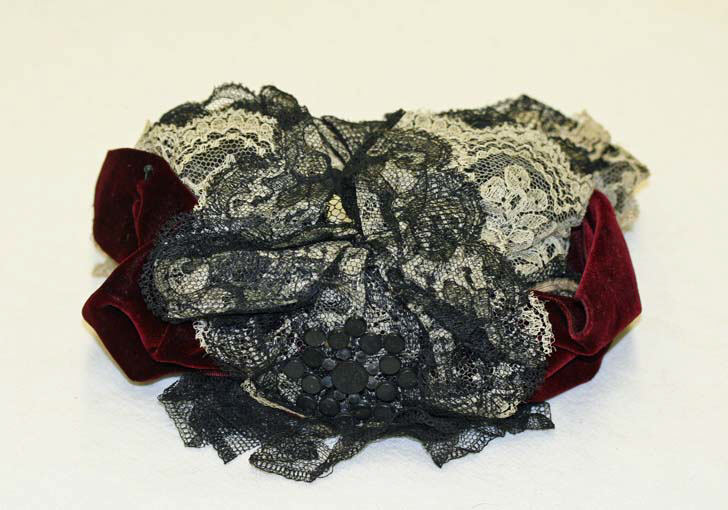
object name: bonnet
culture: american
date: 1870-1879